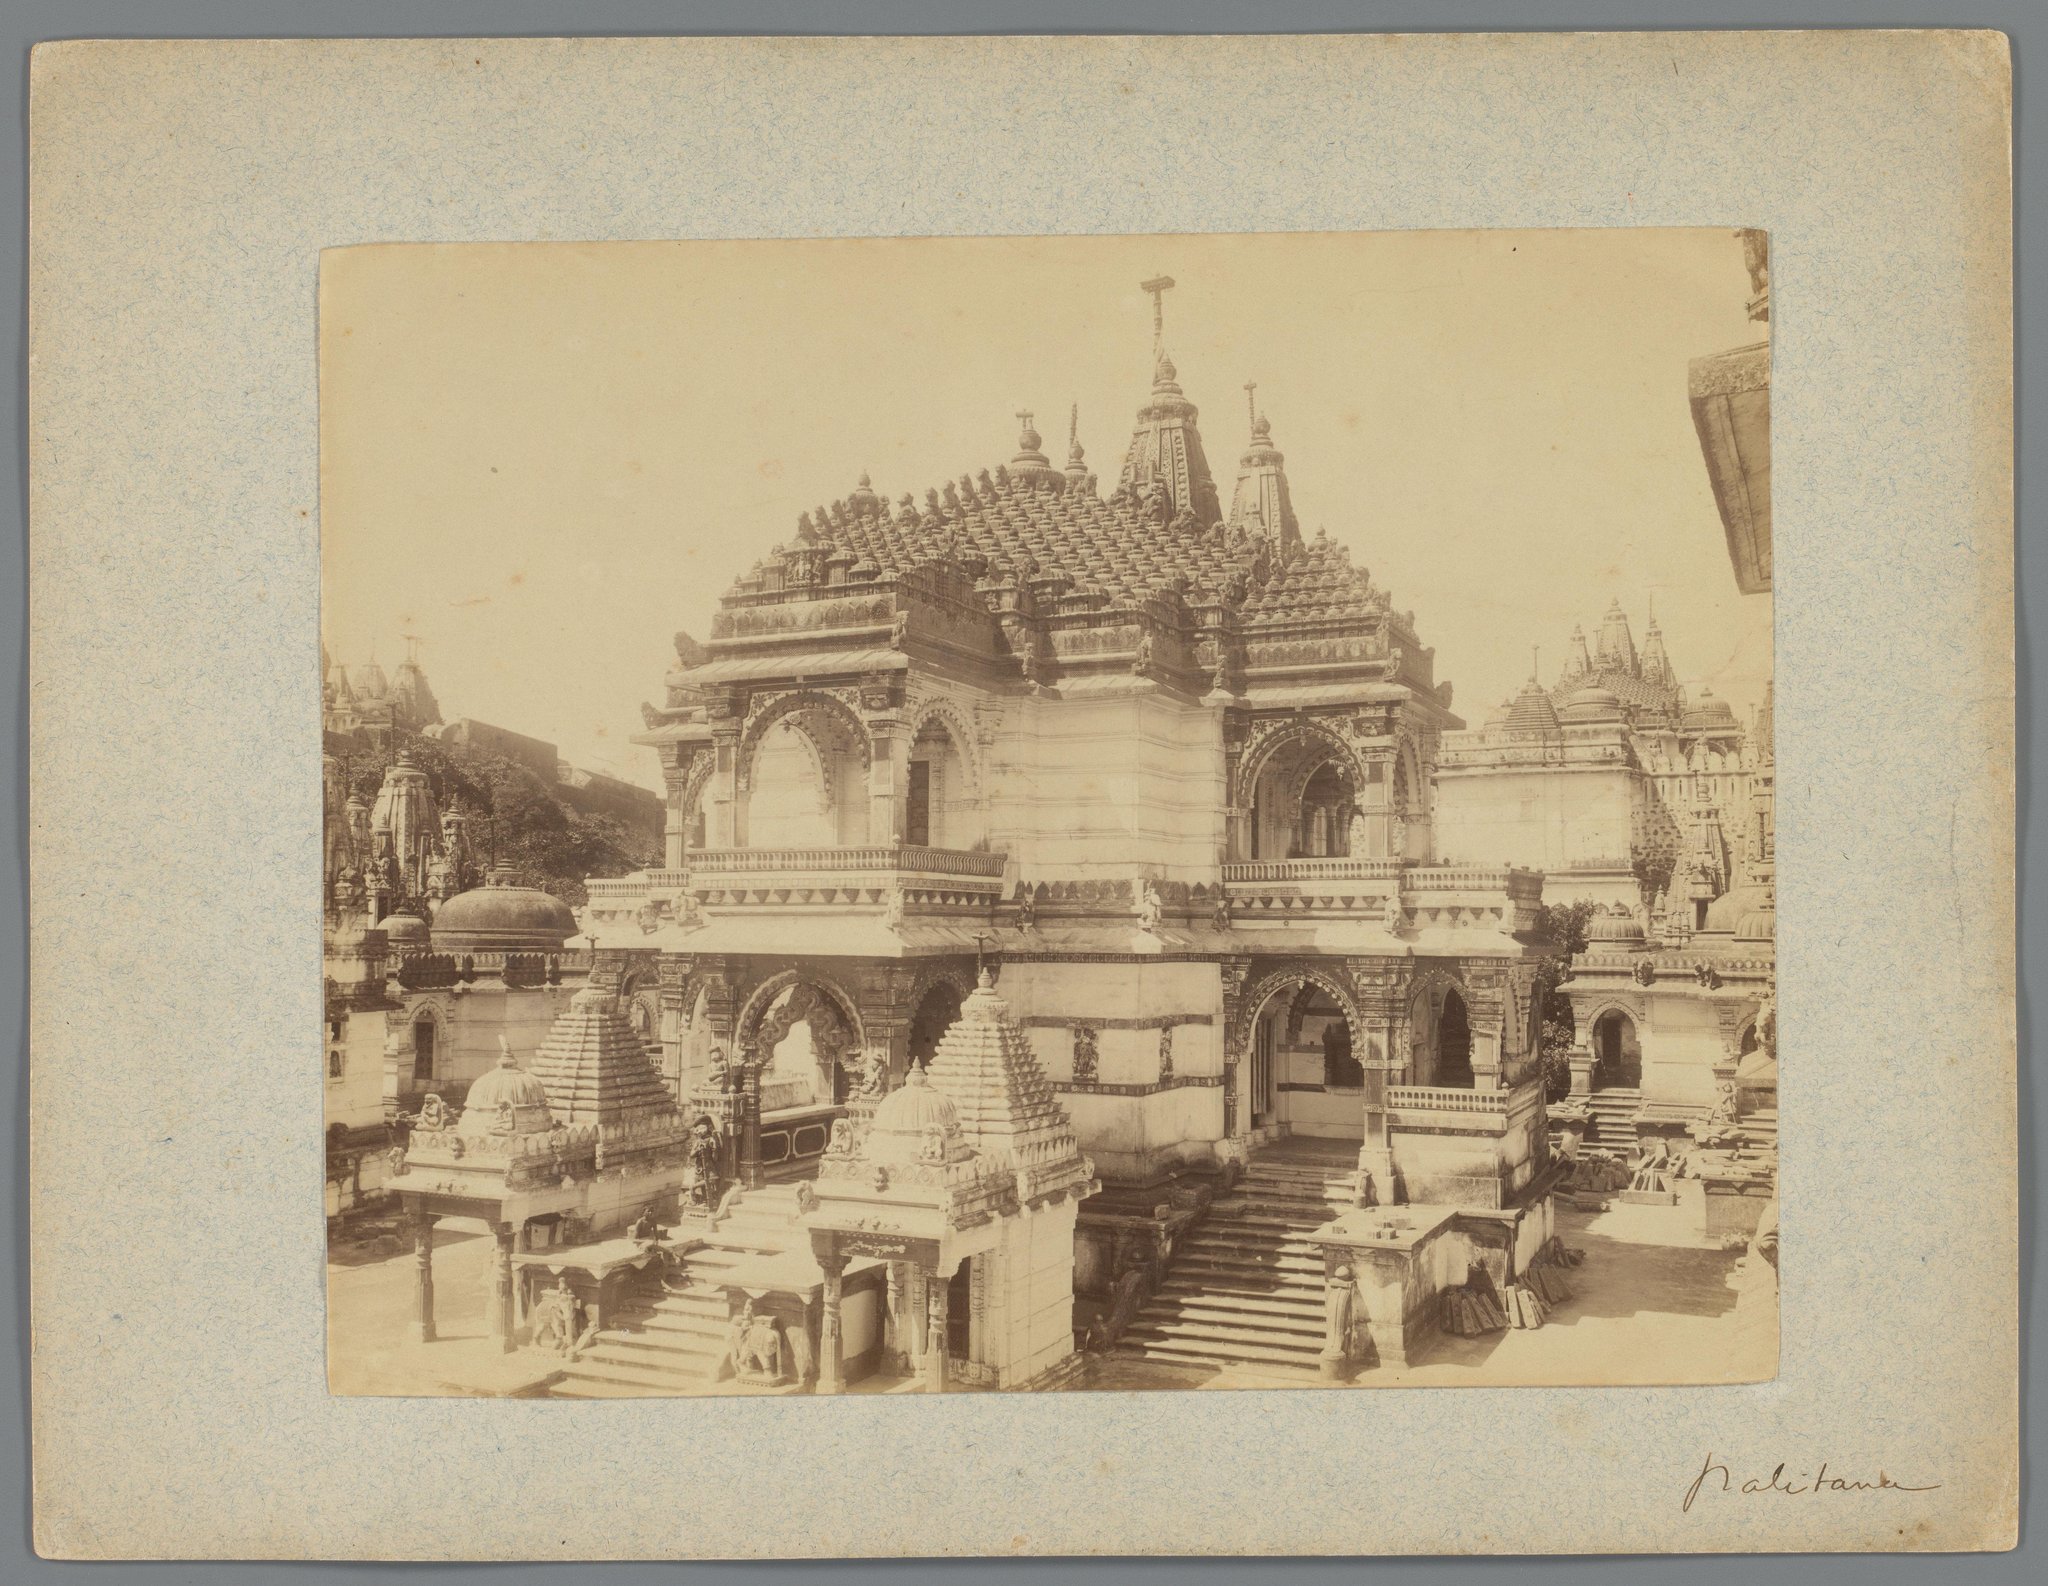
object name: photograph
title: View of temples in Palitana, Gujarat, India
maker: Anonymous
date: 1870-1890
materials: cardboard, photographic support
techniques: albumen print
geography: palitana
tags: temple, shrine ~ hinduism, buddhism, jainism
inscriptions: inscription: ‘Palitana’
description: Op de achterzijde vier schetsen, deels ingekleurd met waterverf.